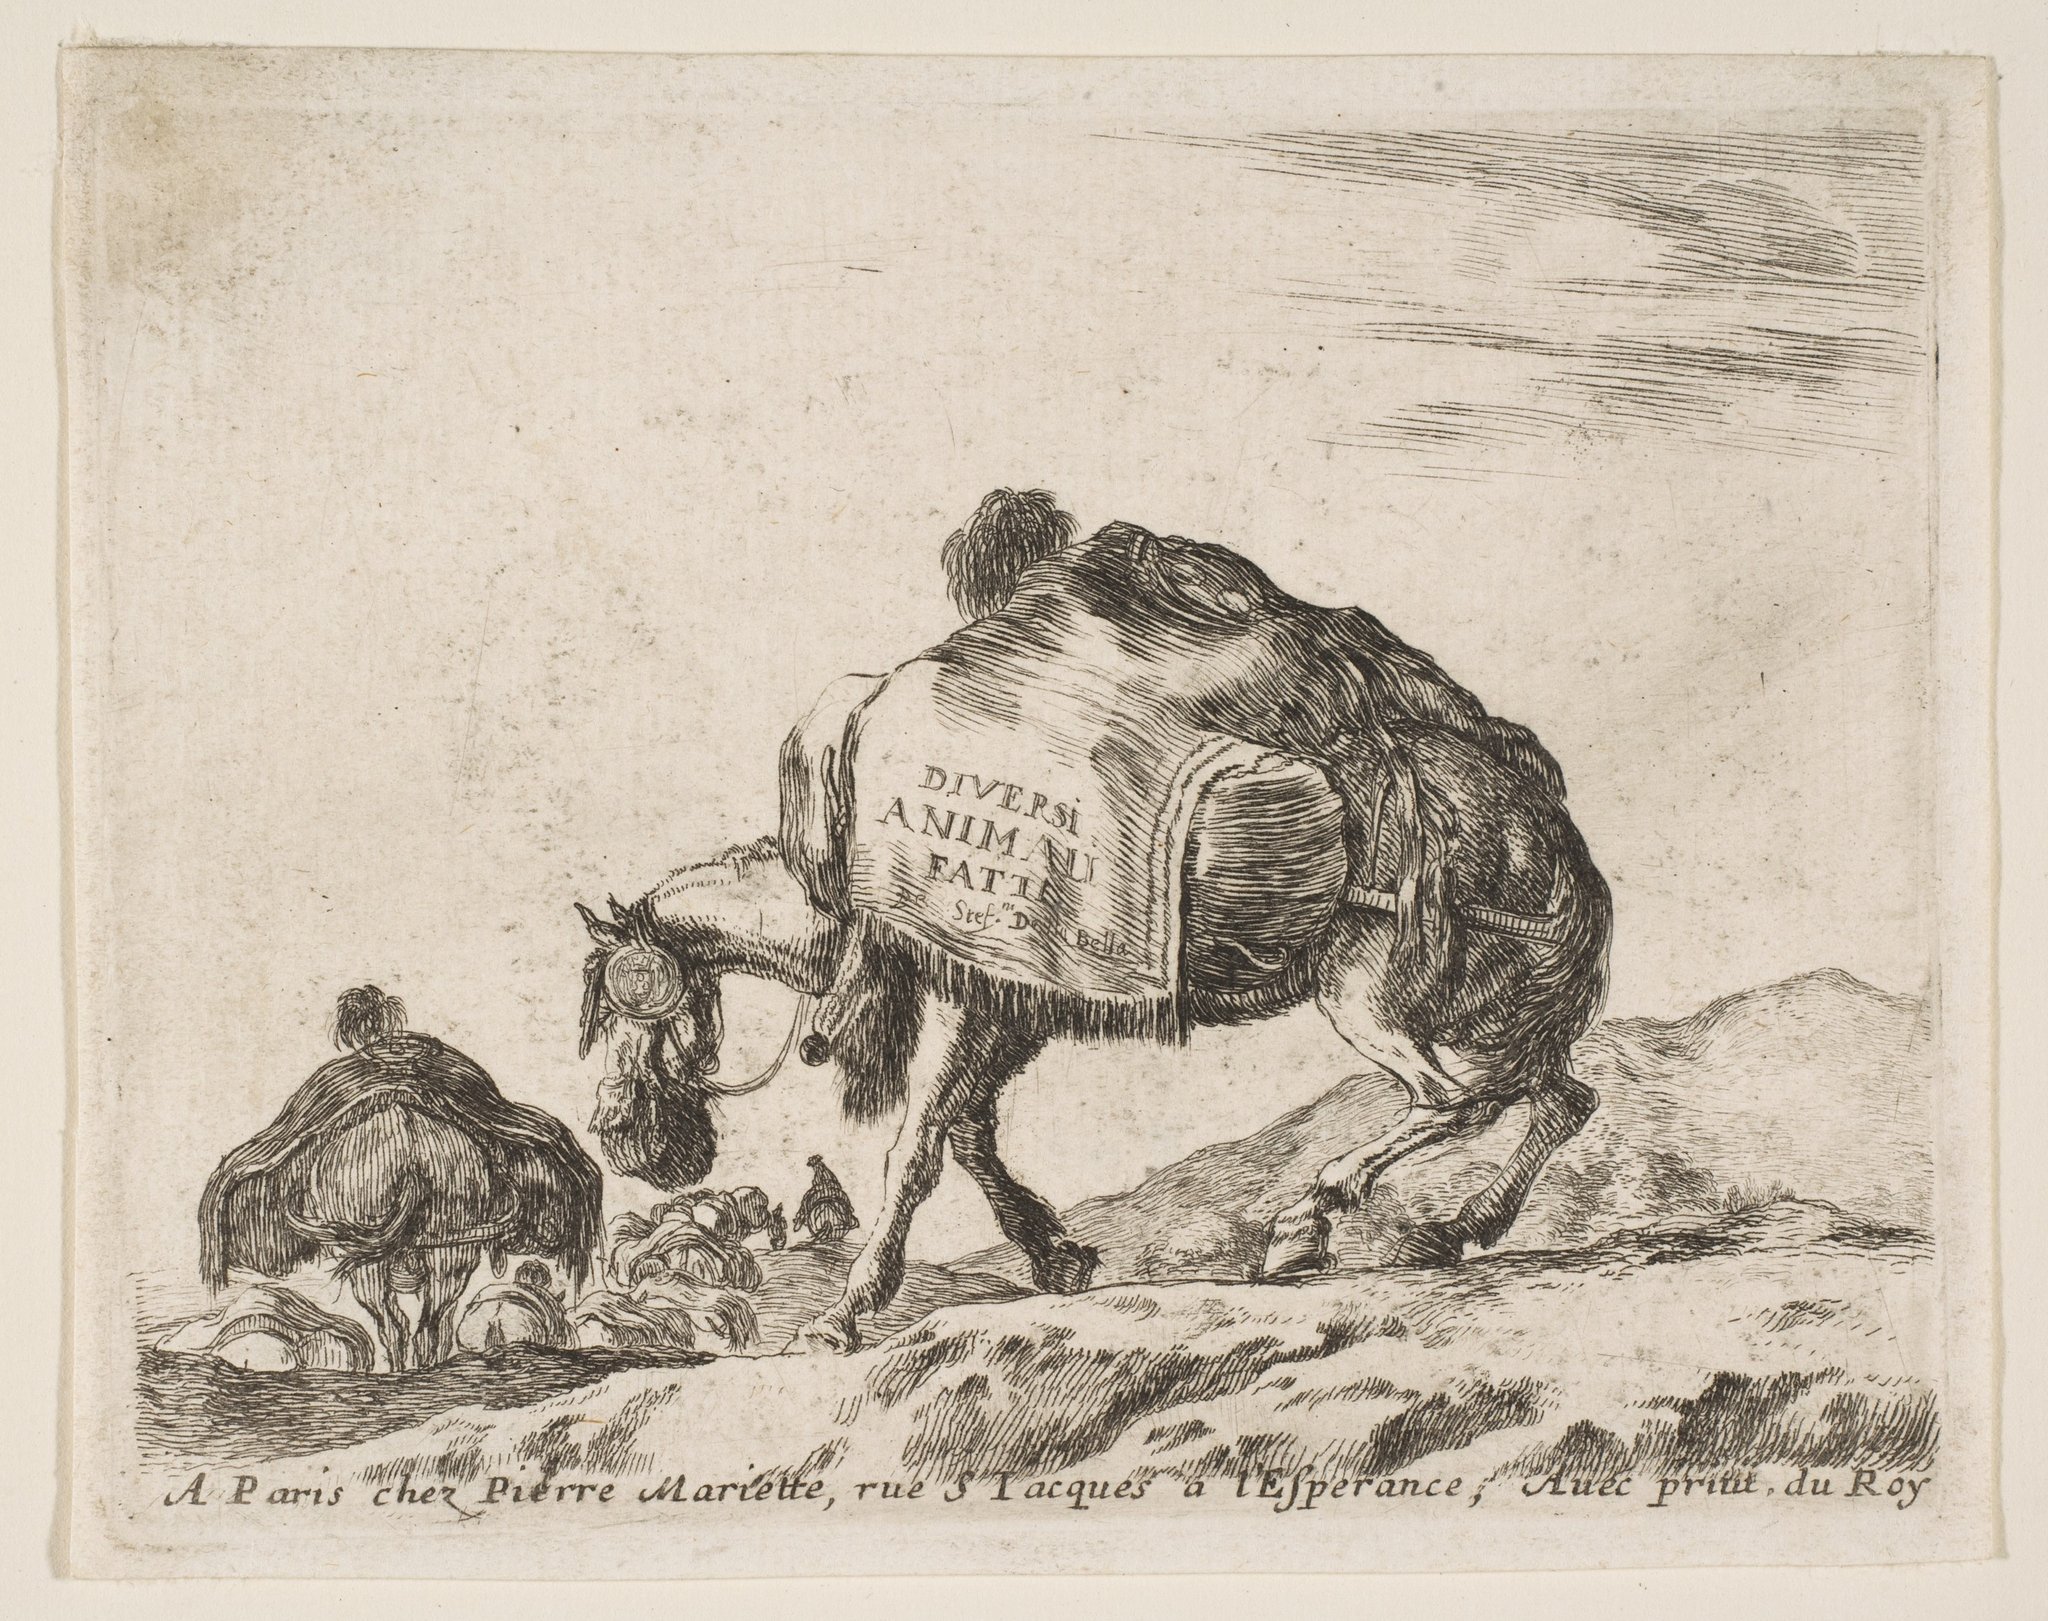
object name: print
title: Pack Horse, frontispiece for "Diversi Animali"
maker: stefano della bella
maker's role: artist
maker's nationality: italian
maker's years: 1610-1664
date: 1641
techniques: etching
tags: horses